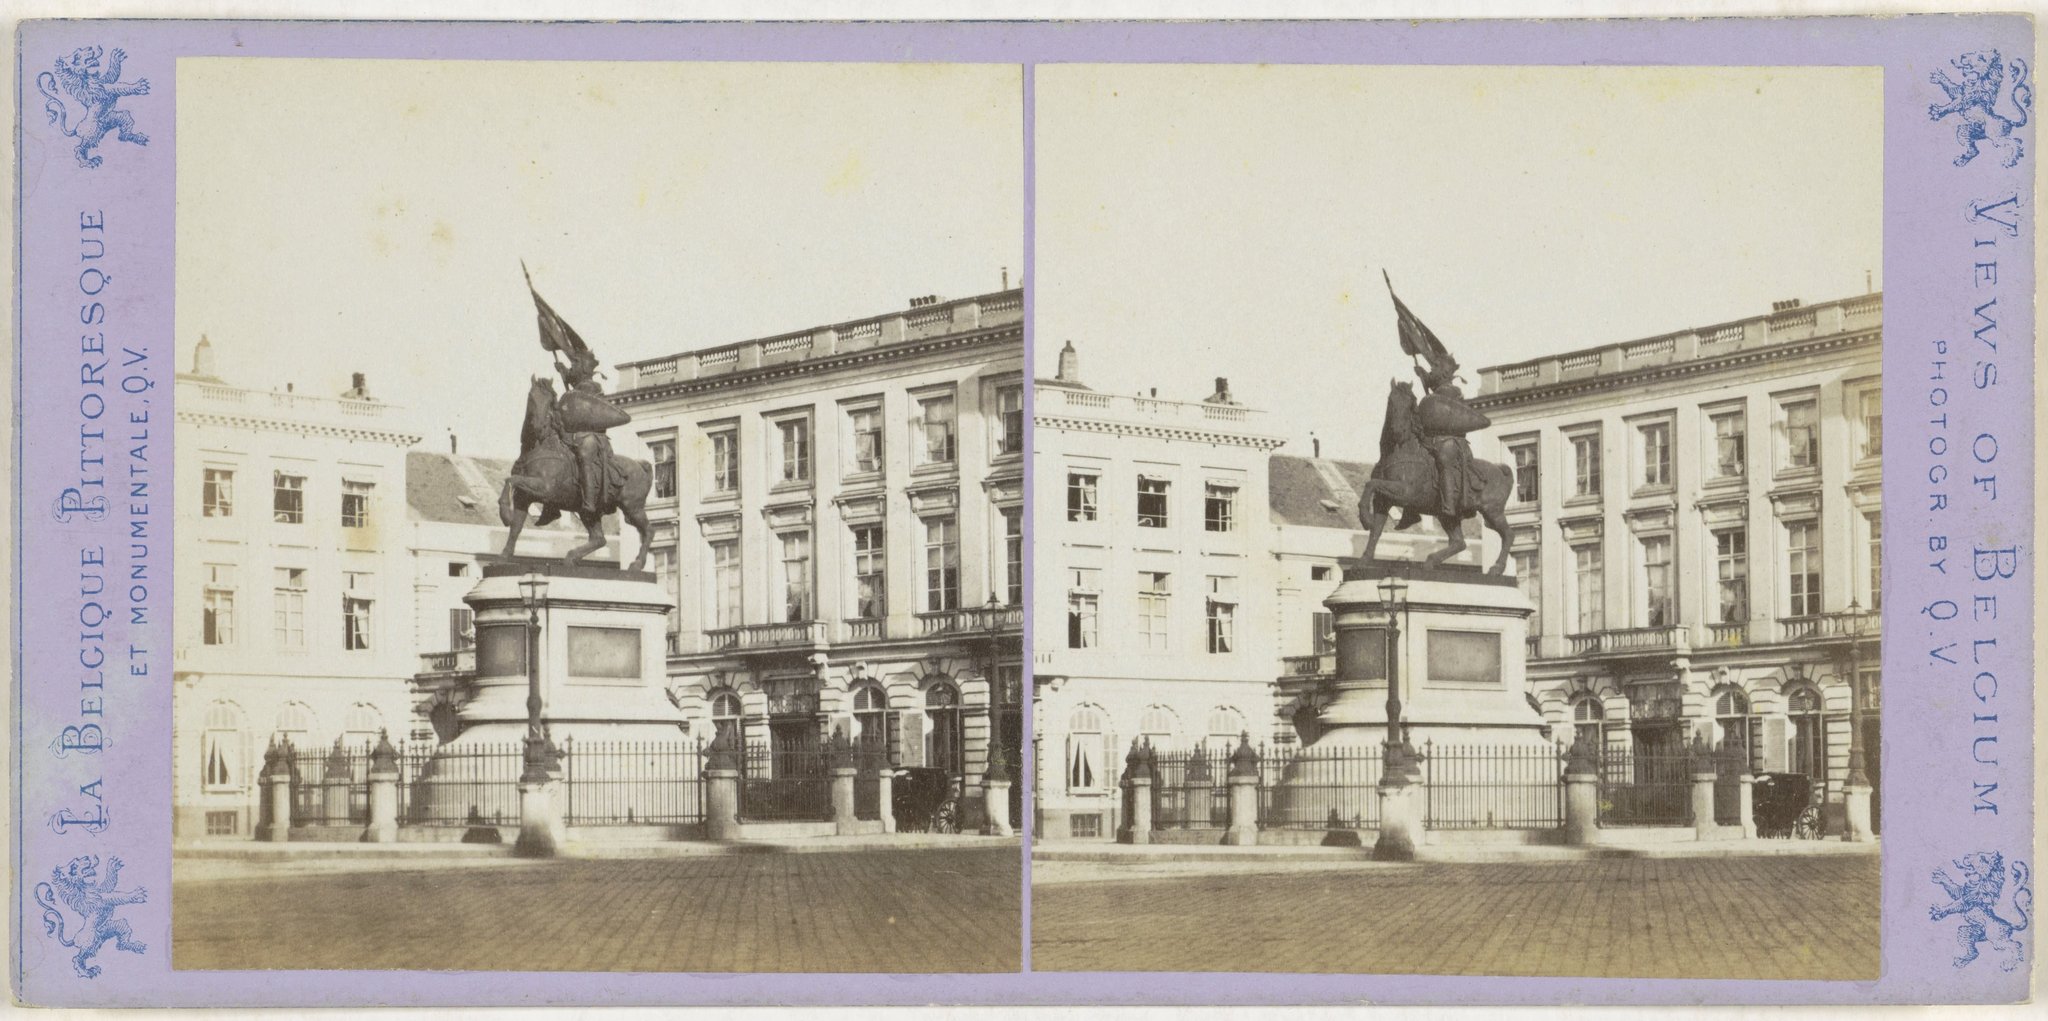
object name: stereograph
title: Standbeeld van Godfried van Bouillon op het Koningsplein in Brussel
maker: jules hippolyte quéval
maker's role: publisher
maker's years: 1824-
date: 1866-1870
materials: cardboard, paper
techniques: albumen print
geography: brussels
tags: godfrey of bouillon, monument, statue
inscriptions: number: ‘No 1619’